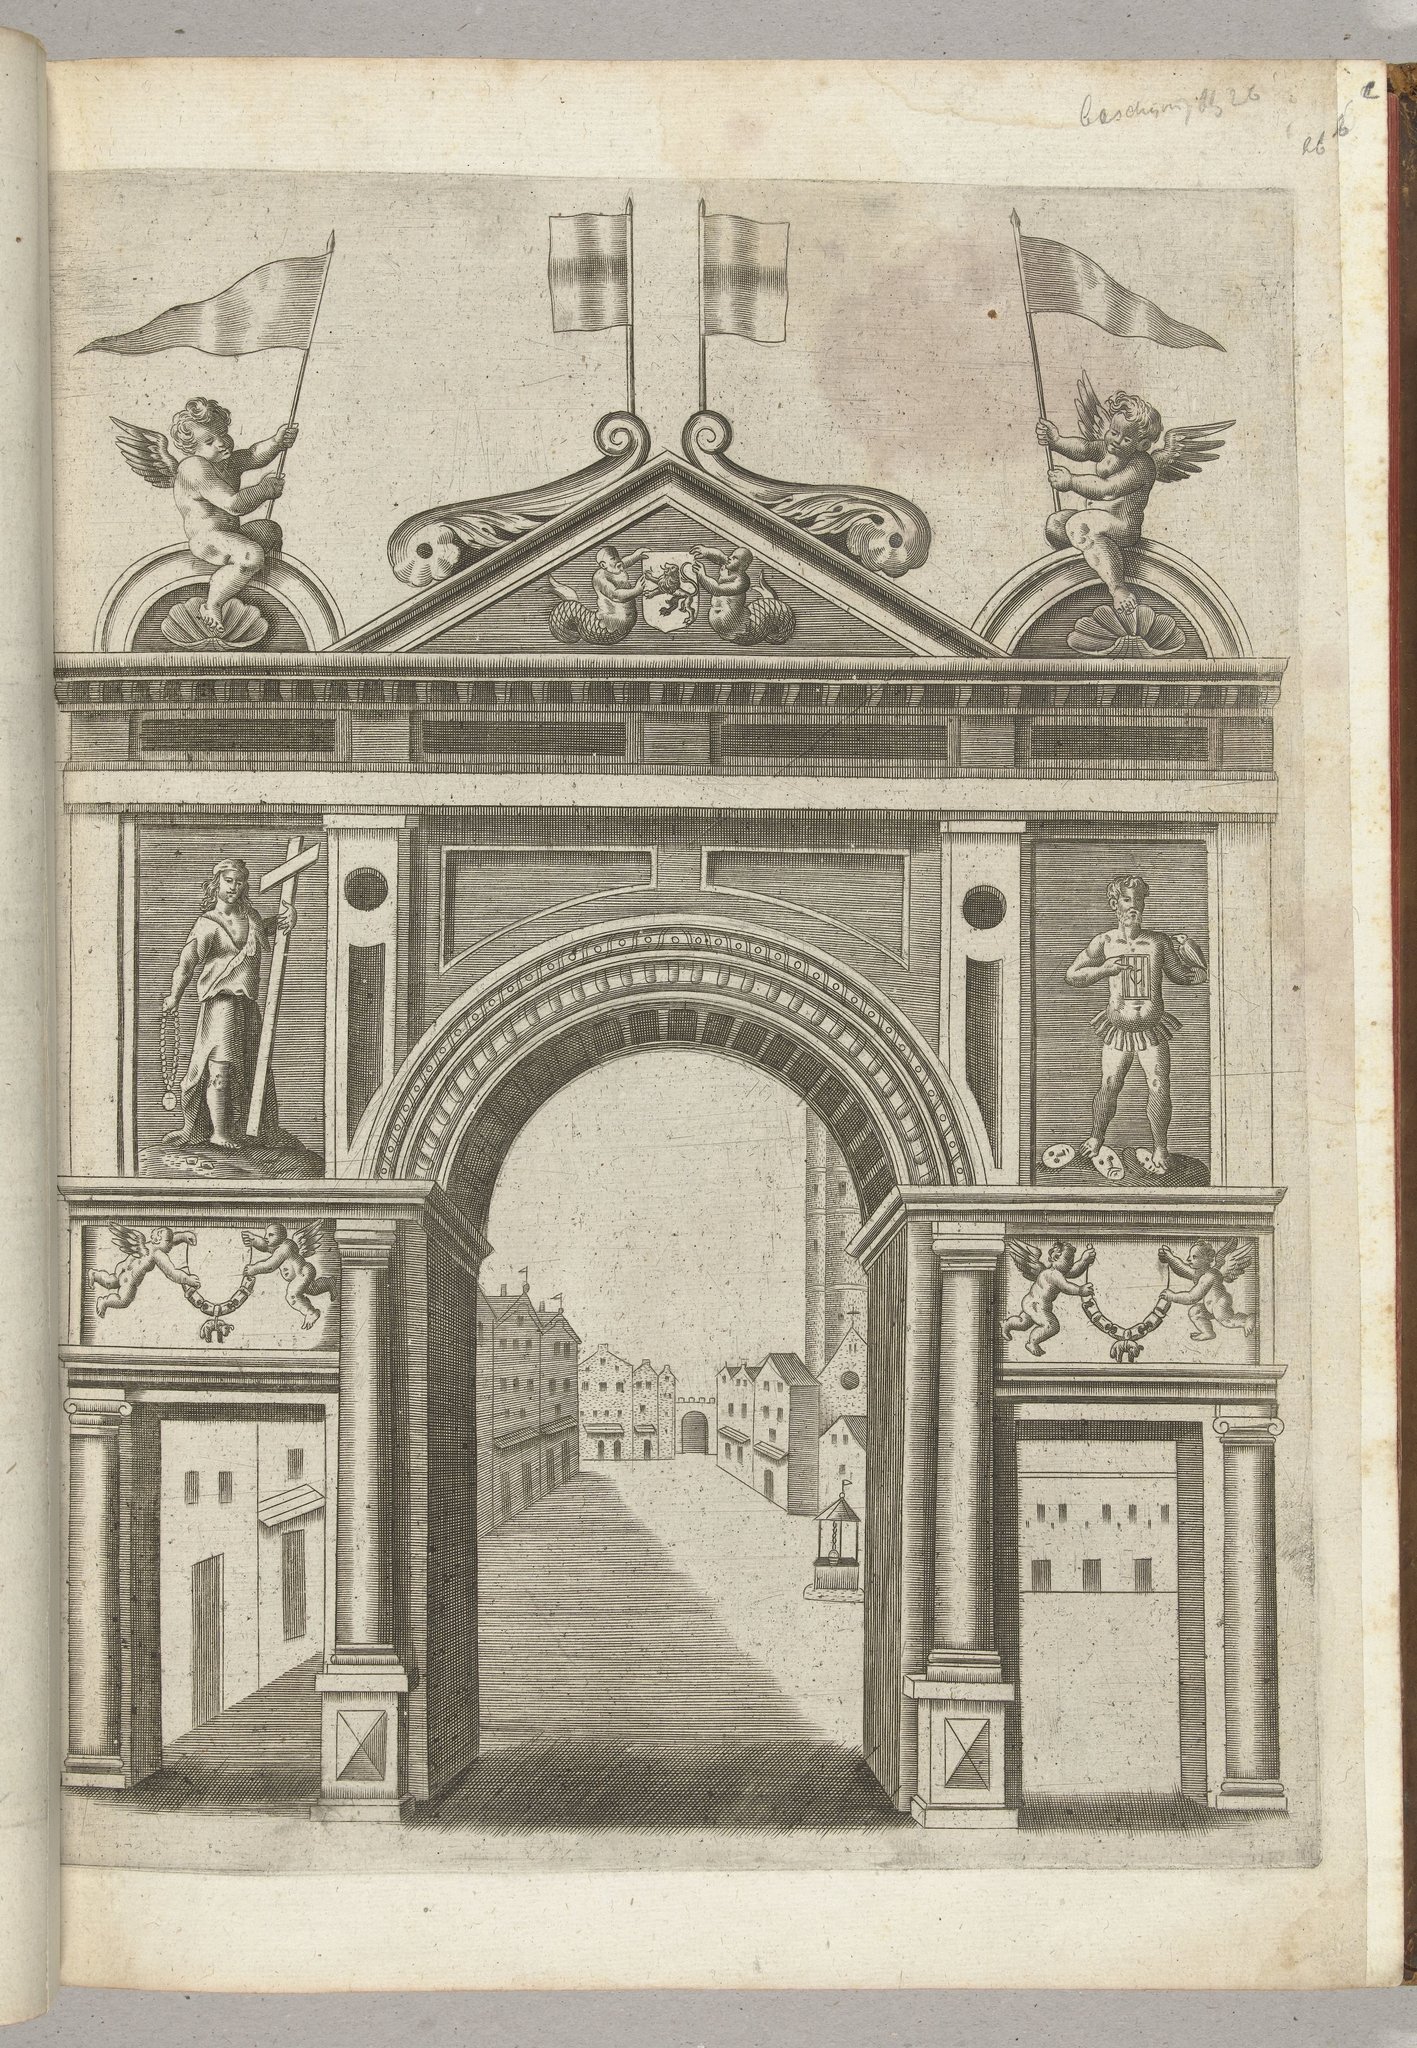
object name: print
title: Triomfpoort met allegorische figuren en putti met de ketting van het orde van de Gulden Vlies, 1594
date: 1594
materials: paper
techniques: engraving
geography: southern netherlands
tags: triumphal entry and public reception, pageant, 'entrée solennelle', 'joyeuse entrée', knighthood order of the golden fleece, brussels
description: Triomfpoort met twee allegorische figuren en twee putti met de ketting van het orde van de Gulden Vlies. Feestelijke intocht van aartshertog Ernst als gouverneur der Nederlanden gehouden te Brussel op 30 januari 1594. Onderdeel van de beschrijving van deze intocht Descriptio et explicatio pegmatum, arcuum spectaculorum quae Bruxellae Brabant. pridie Cal. Febr. Ao. 1594 exhibita fuere, sub ingressum ... Ernesti ... Archiducis Austriae ... pro Philippo II. Belgicae ditionis gubernatore, J. Mommaert, Brussel 1594.